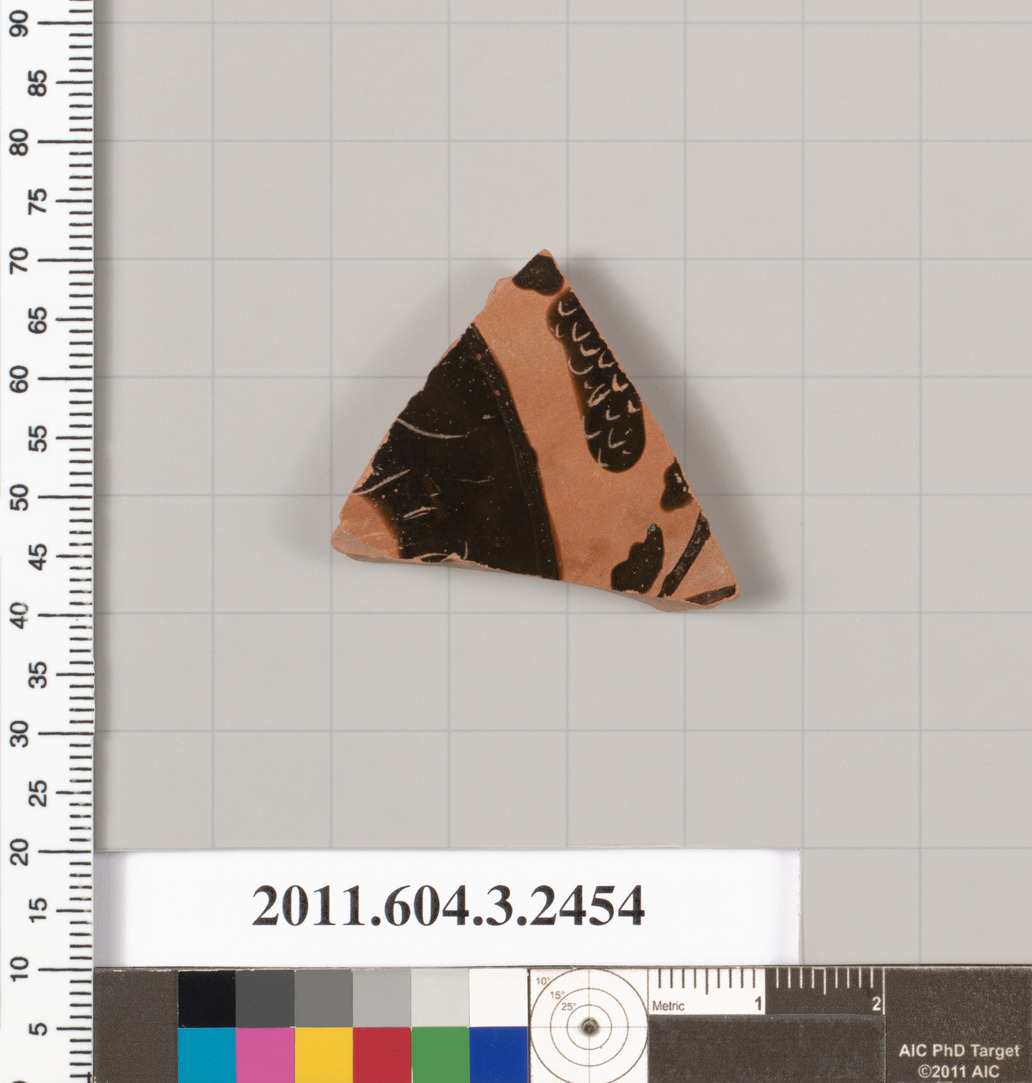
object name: kylix fragment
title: Terracotta fragment of a kylix: eye-cup (drinking cup)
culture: greek, attic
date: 530-510 BCE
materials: terracotta